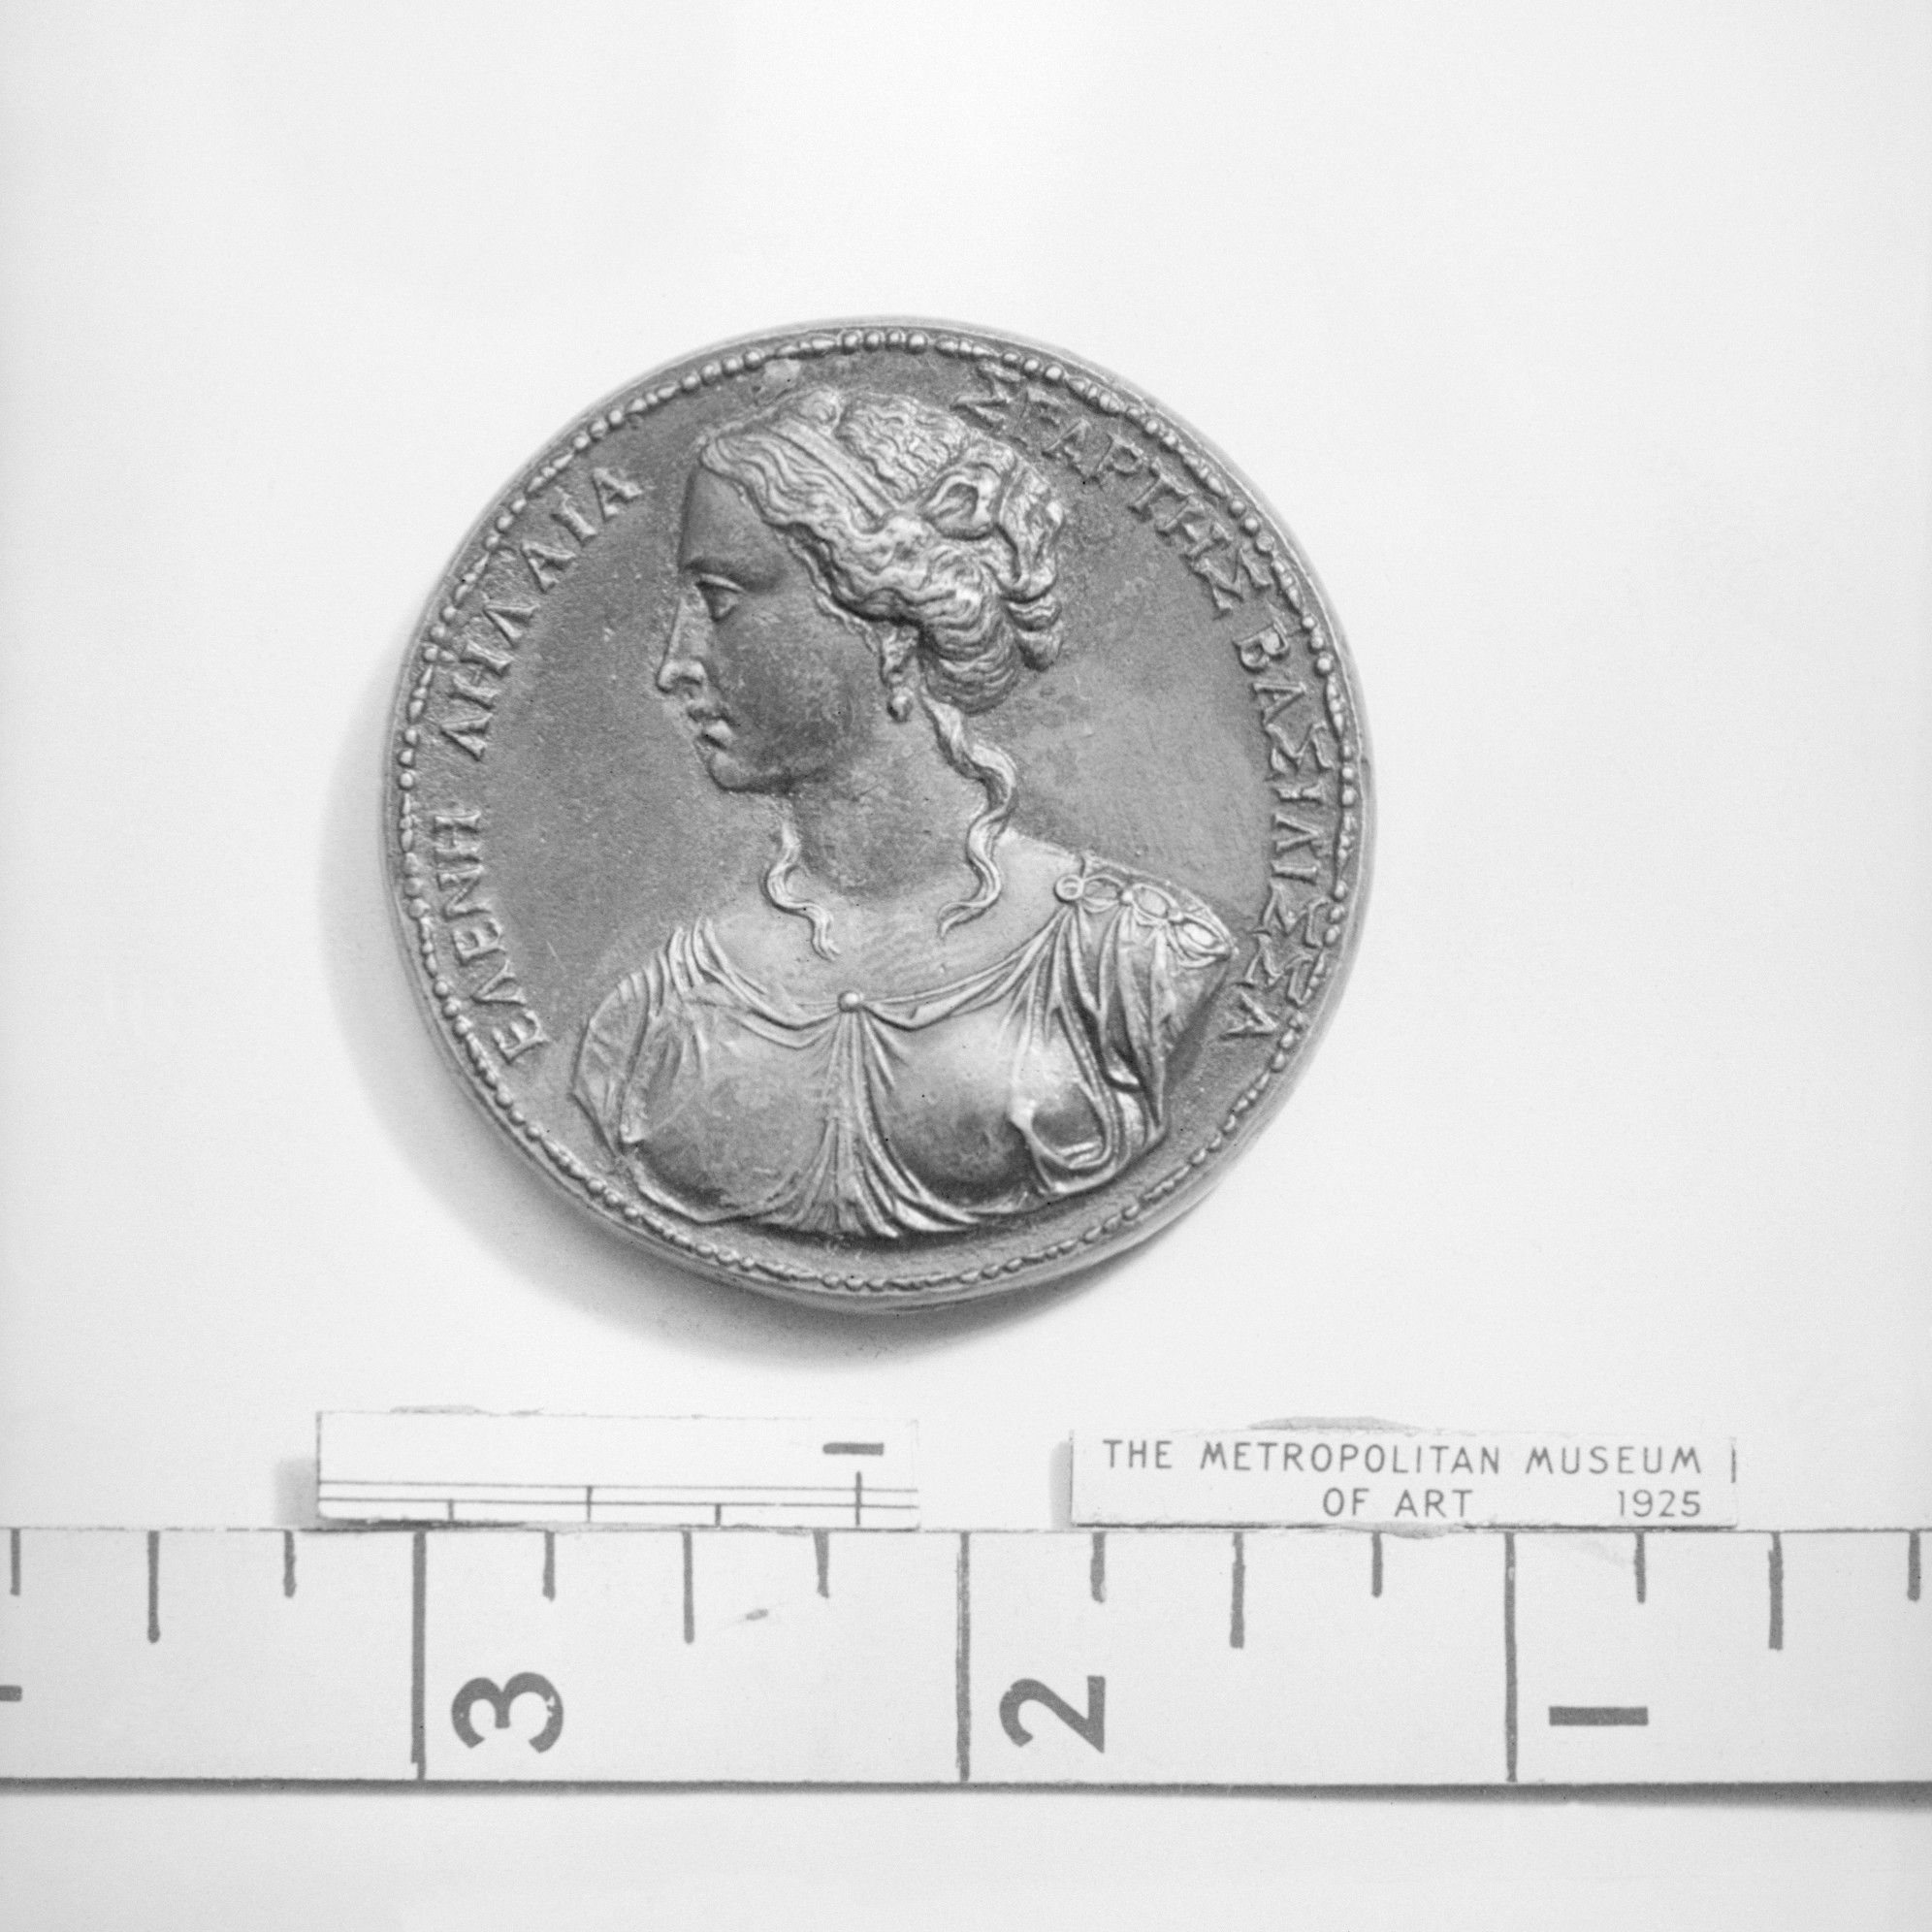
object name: medal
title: Helen of Sparta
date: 1501-1600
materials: bronze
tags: profiles,women